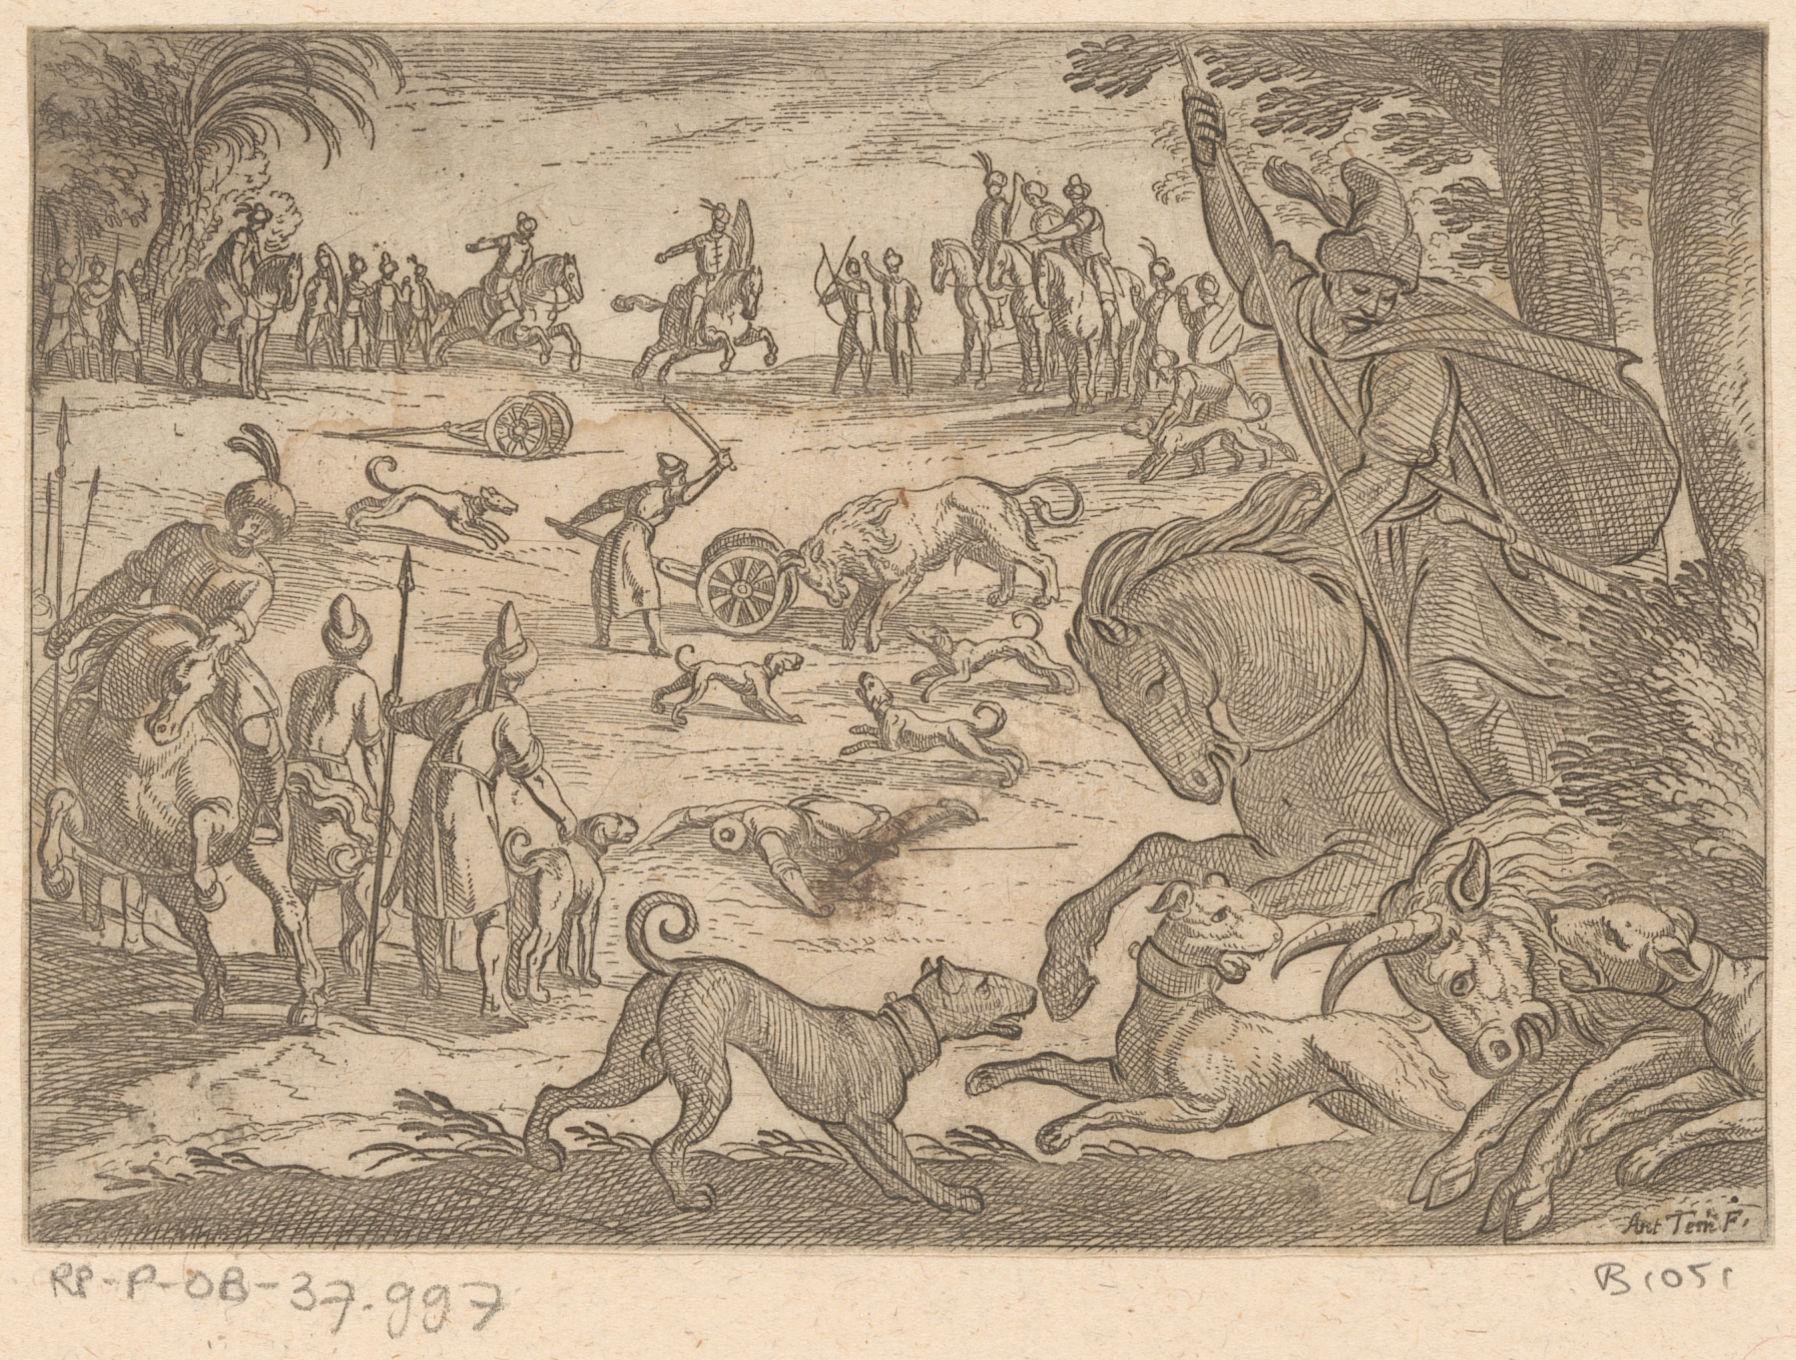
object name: print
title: Primo libro di caccie varie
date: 1598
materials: paper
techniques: etching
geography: vatican city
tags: bull, hunter, hunters hunting (n.b.: in 1988-1990 this notation denoted the concept of 43c11421 'hunters resting during the hunt'), hunt ~ mammals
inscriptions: collector's mark: Lugt 2165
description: Landschap met jagers die jagen op wilde stieren. Op de voorgrond rechts een jager te paard die een stier steekt met zijn speer.